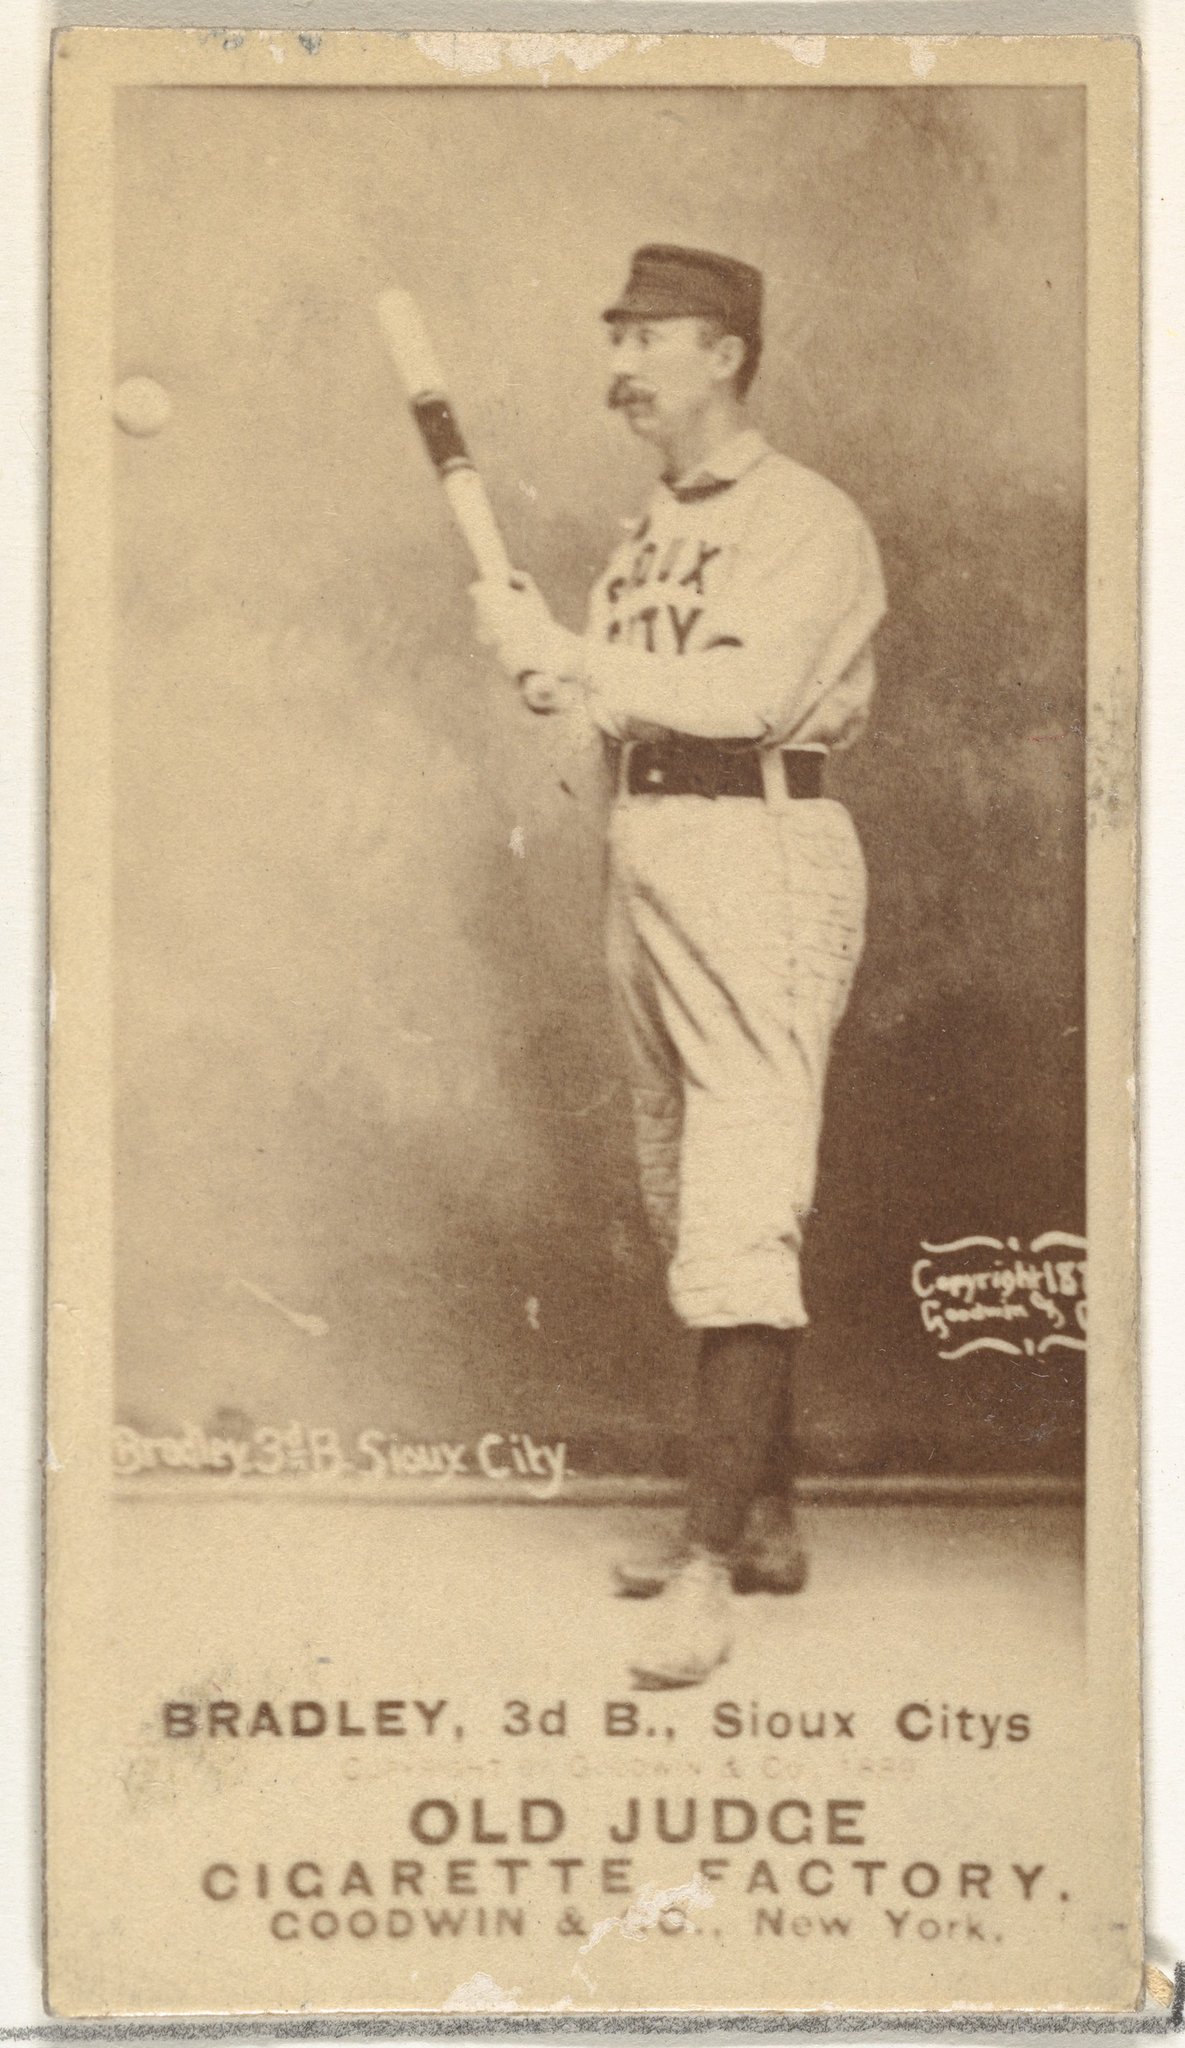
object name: baseball card, photograph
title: George Washington "Grin" Bradley, 3rd Base, Sioux City Corn Huskers, from the Old Judge series (N172) for Old Judge Cigarettes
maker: goodwin & company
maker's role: publisher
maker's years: 1850-1950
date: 1889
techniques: albumen silver print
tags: men,portraits,baseball,athletes